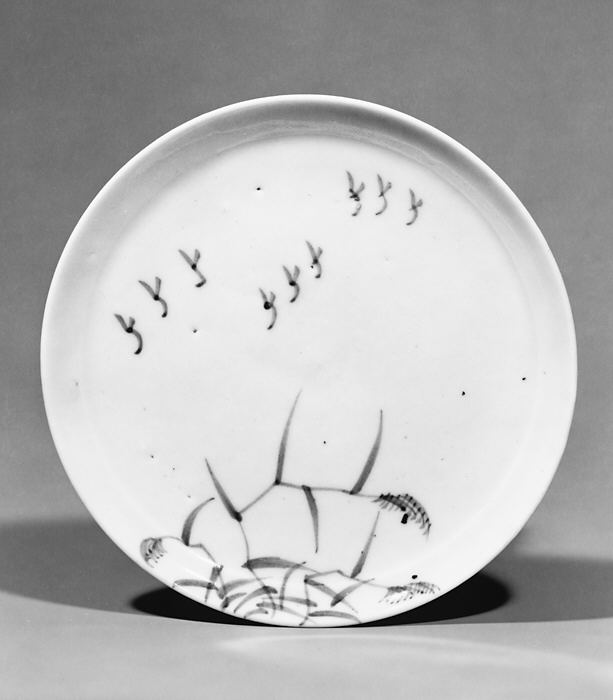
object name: dish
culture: japanese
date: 1615-1868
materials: porcelain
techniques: underglaze